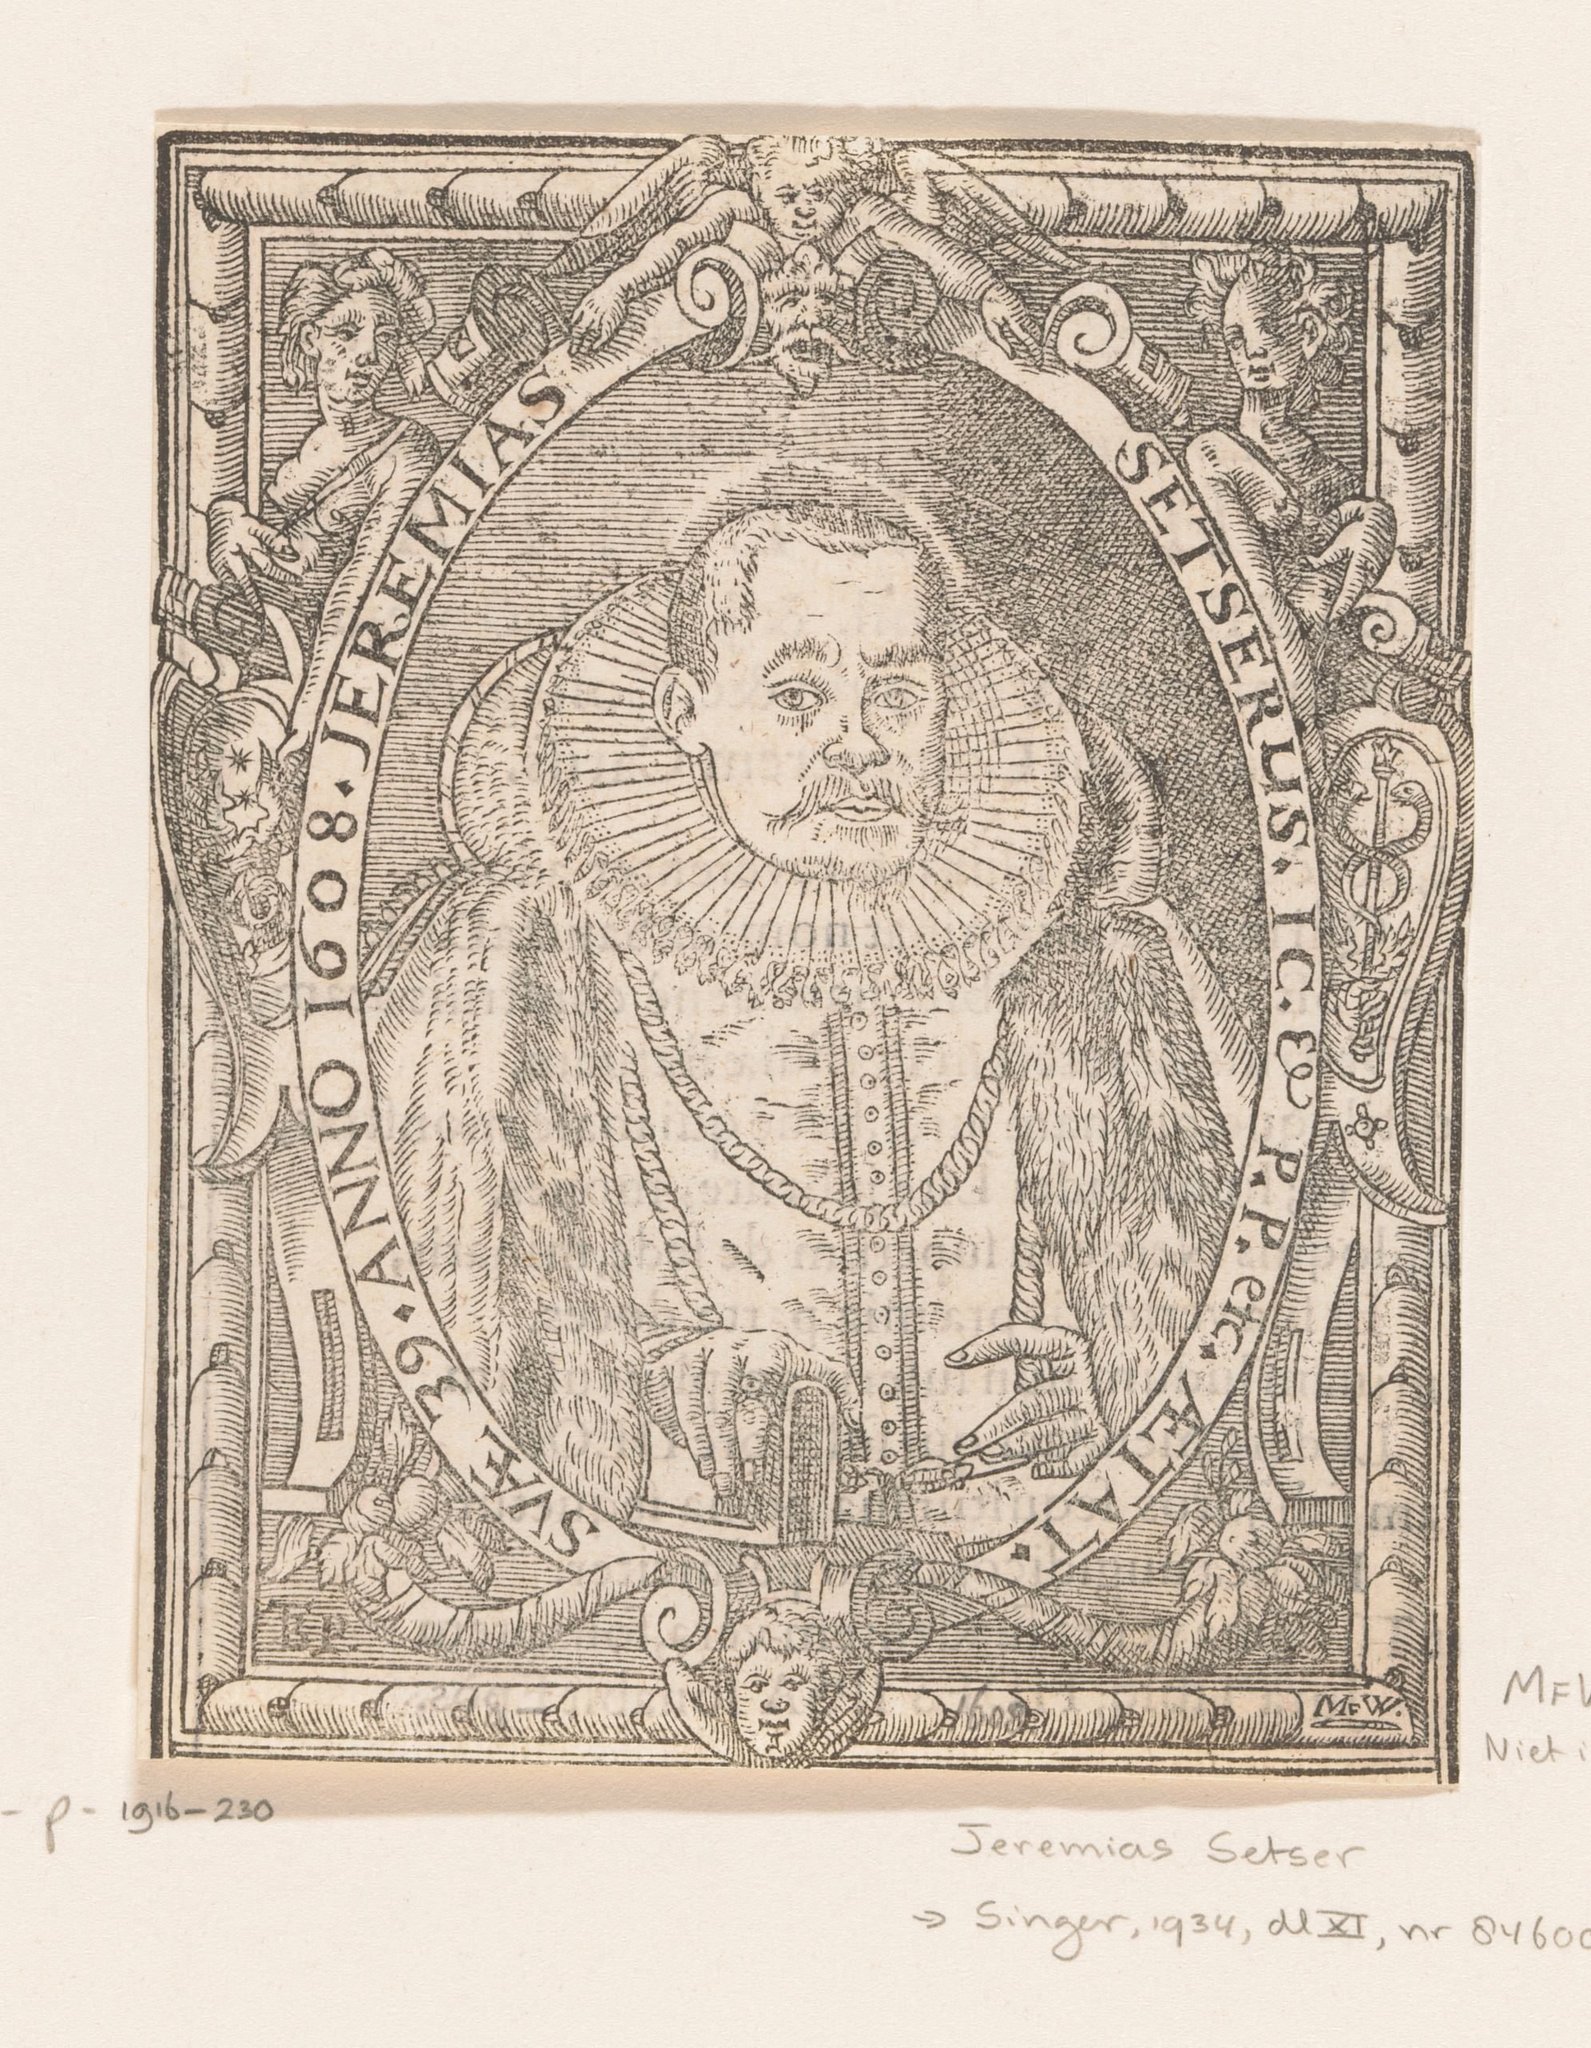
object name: book illustration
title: Portret van Jeremias Setzer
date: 1608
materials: paper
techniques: woodcut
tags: historical persons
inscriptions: date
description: Prent afkomstig uit een onbekende publicatie.